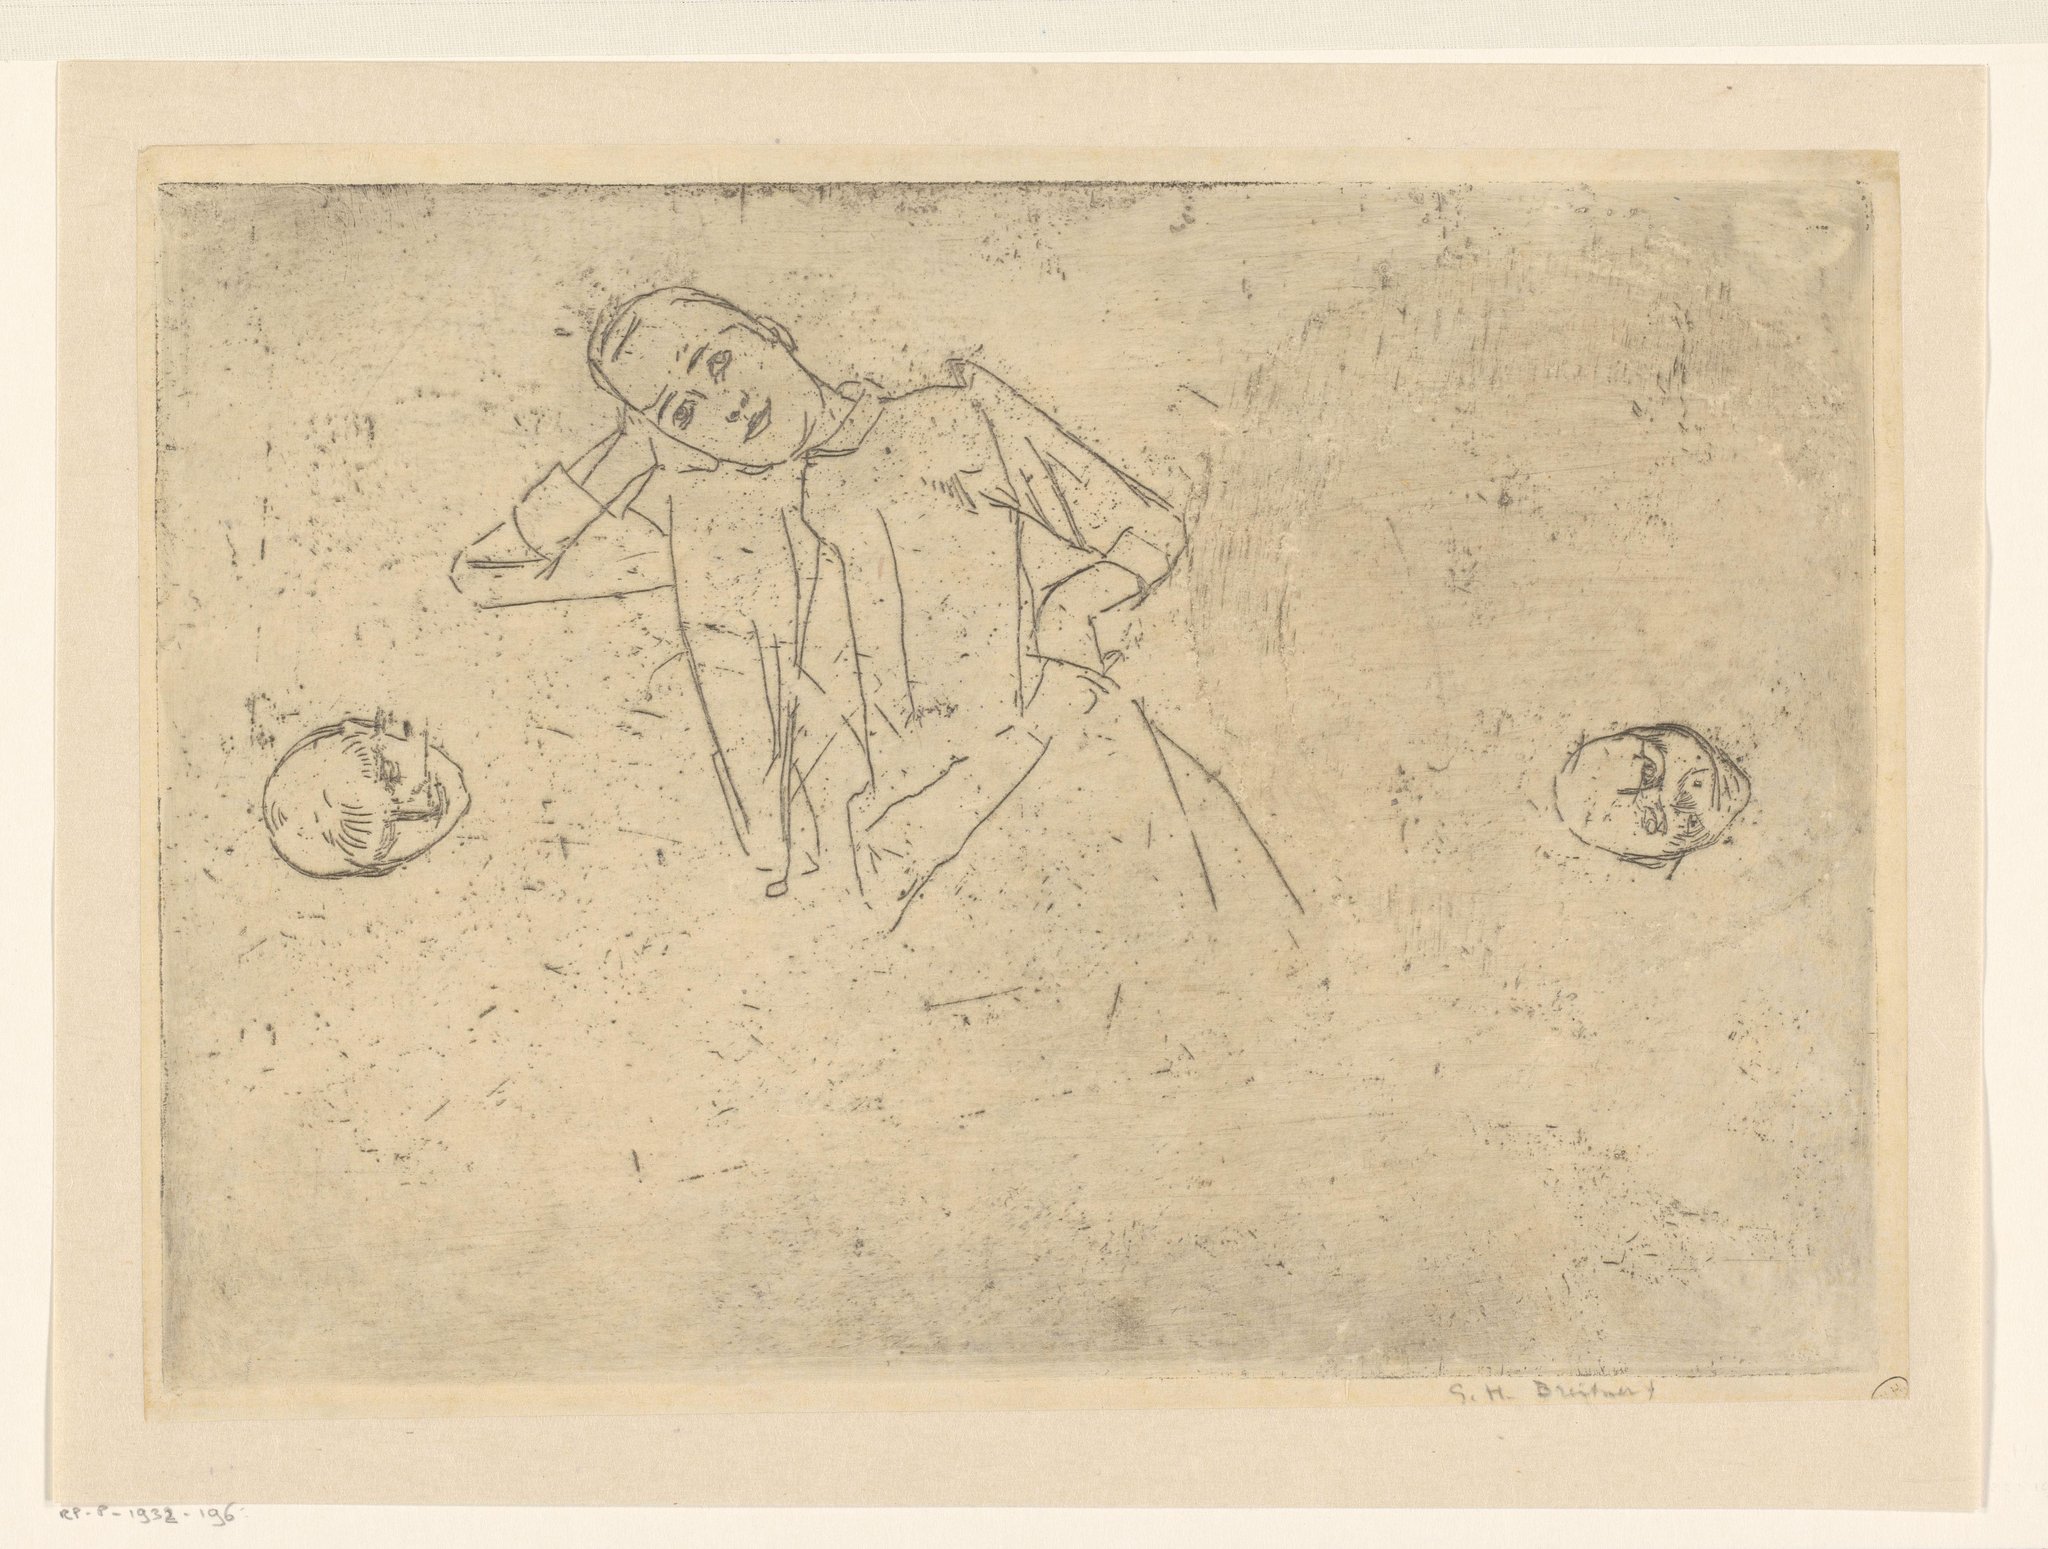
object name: print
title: Studie zittende vrouw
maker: george hendrik breitner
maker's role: draughtsman, painter, print maker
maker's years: 1857-1923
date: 1891-1892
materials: paper, ink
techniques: etching, intaglio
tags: adult woman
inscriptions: signature: ‘G.H. Breitner f’, collector's mark: Lugt 2228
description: Studie van een zittende vrouw, het hoofd op de hand geleund, met links en rechts een studiekop.